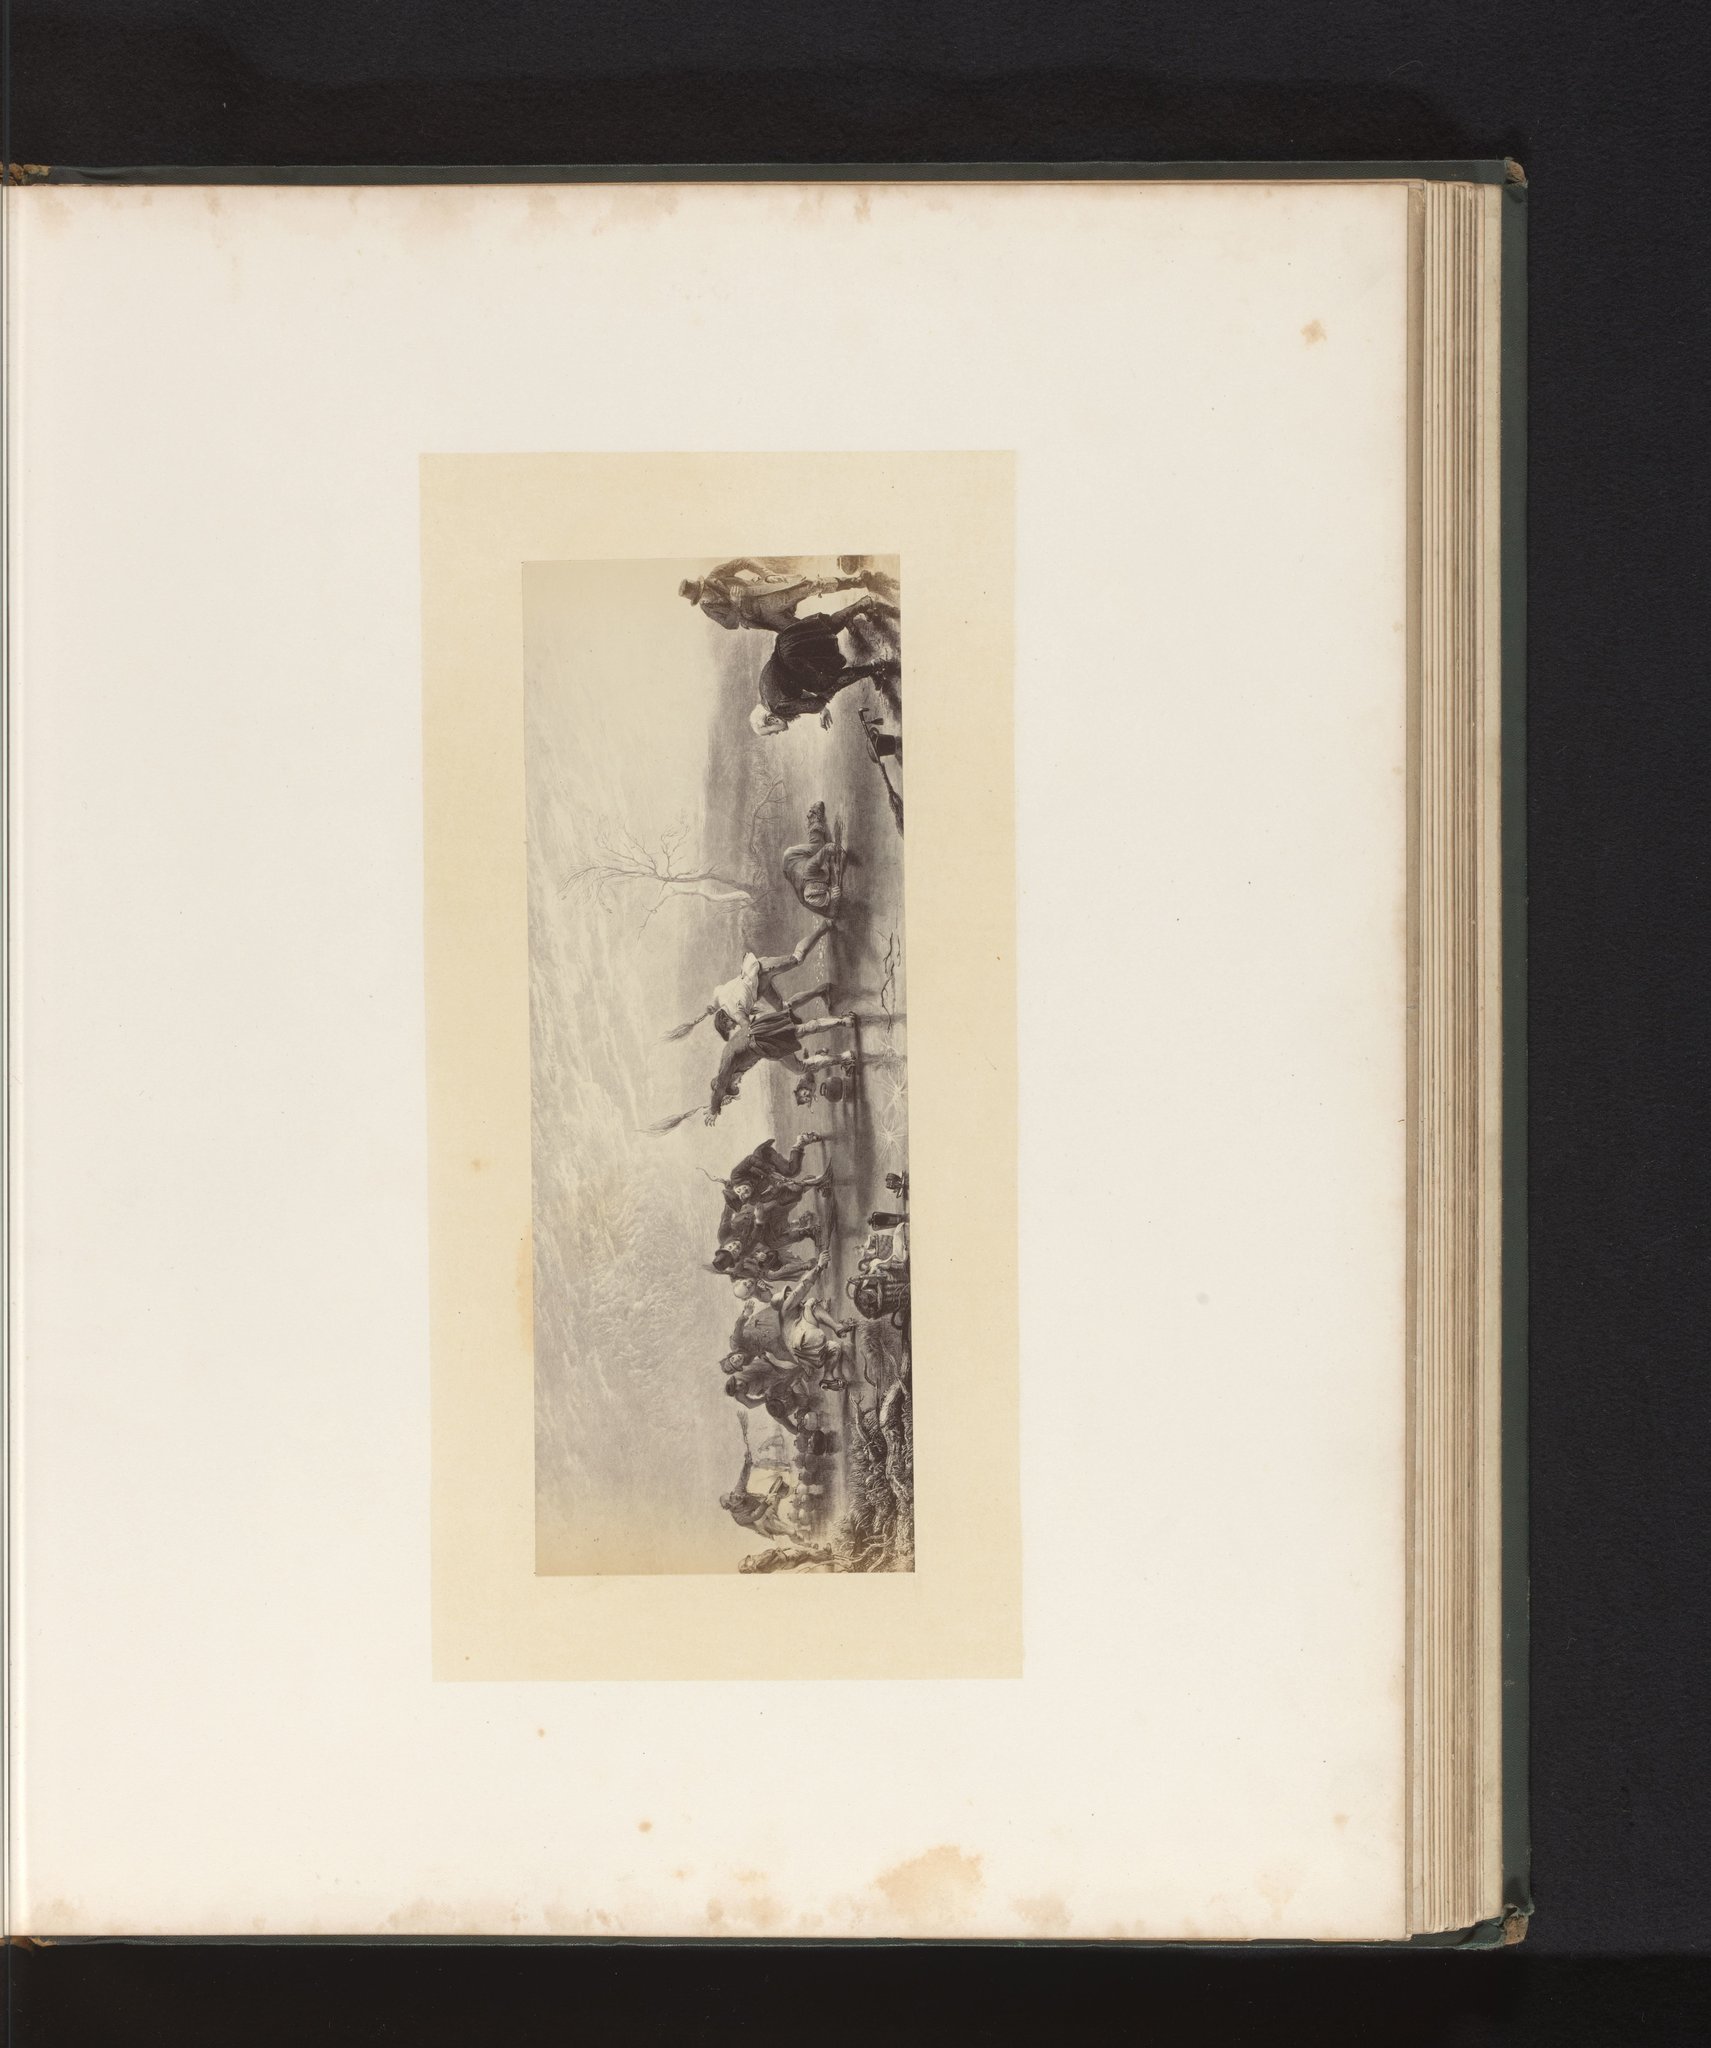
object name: page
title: Fotoreproductie van een gravure van Curlers, naar het schilderij door Sir George Harvey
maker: thomas annan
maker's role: fotograaf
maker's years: 1829-1887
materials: photographic support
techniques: albumen print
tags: winter sports